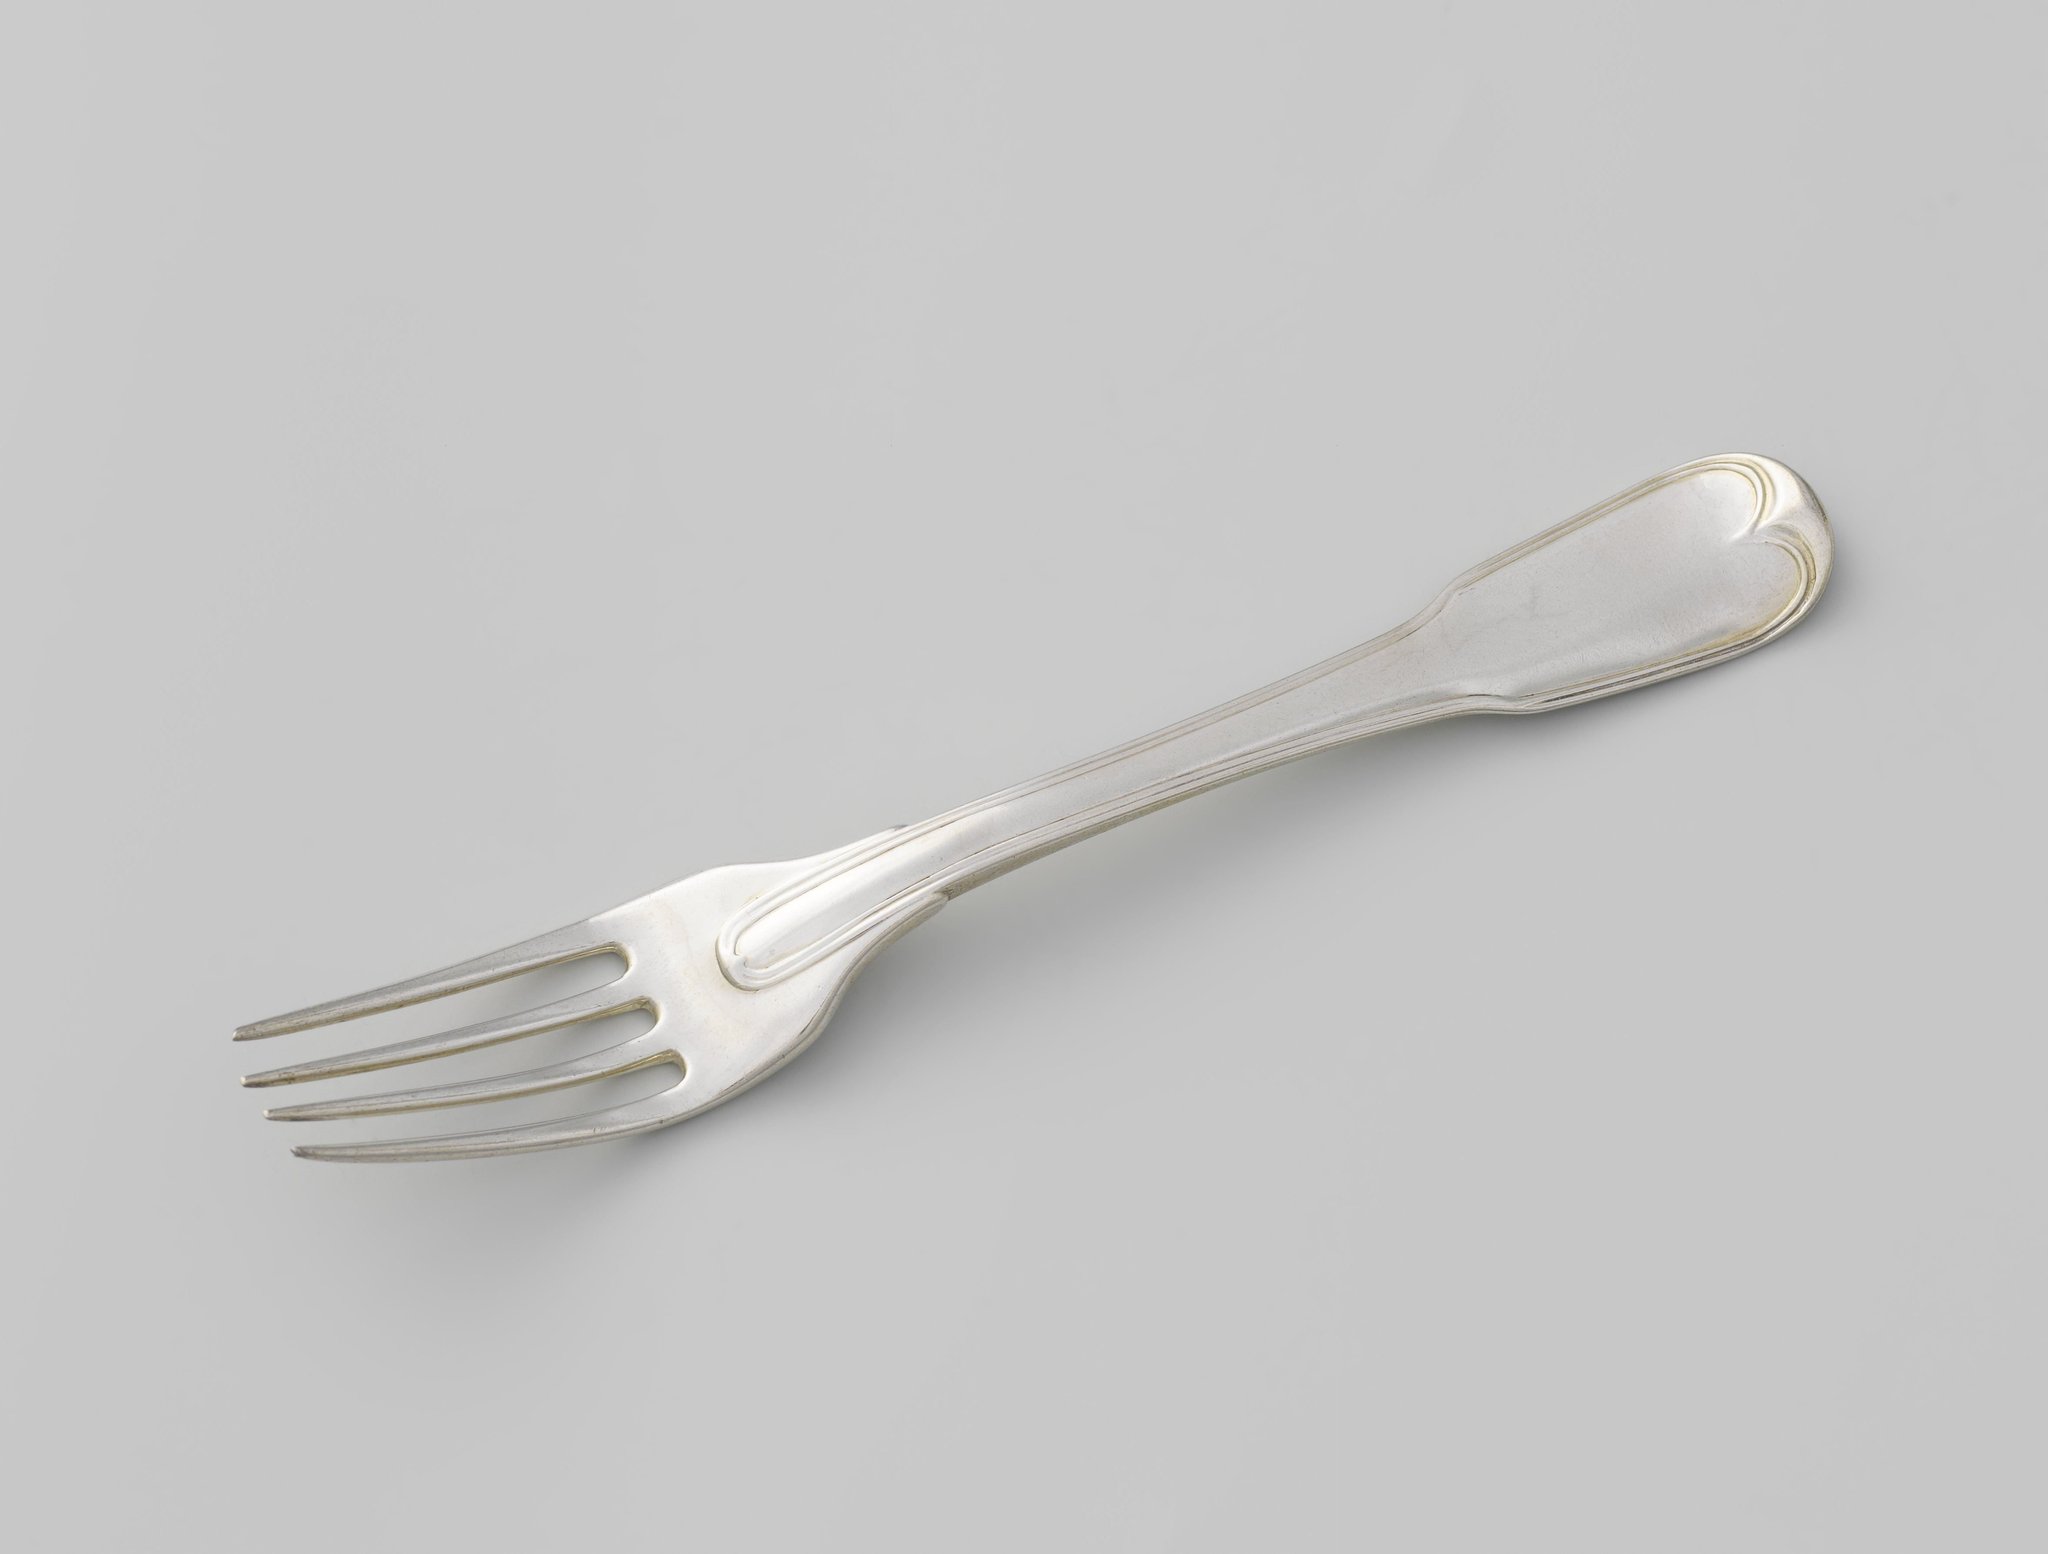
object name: fork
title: Vork met het helmteken Clifford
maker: roelof helweg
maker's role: silversmith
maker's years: 1758-1843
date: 1806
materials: silver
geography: amsterdam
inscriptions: alloy mark: ‘Hollandse leeuw’, maker's mark: ‘RH in ovaal’, date letter: ‘X (=1806)’, town mark: ‘Amsterdam’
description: De viertandige vork is aan zowel boven- als onderzijde door middel van enkel lof verbonden met de platte, gebogen steel, die zich verbreedt naar het spatelvormige uiteinde. Boven- en onderzijde van de steel worden omgeven door een dubbele filetrand, die bij het uiteinde ingezwenkt is. Op de onderzijde van de spatel is het helmteken Clifford gegraveerd.